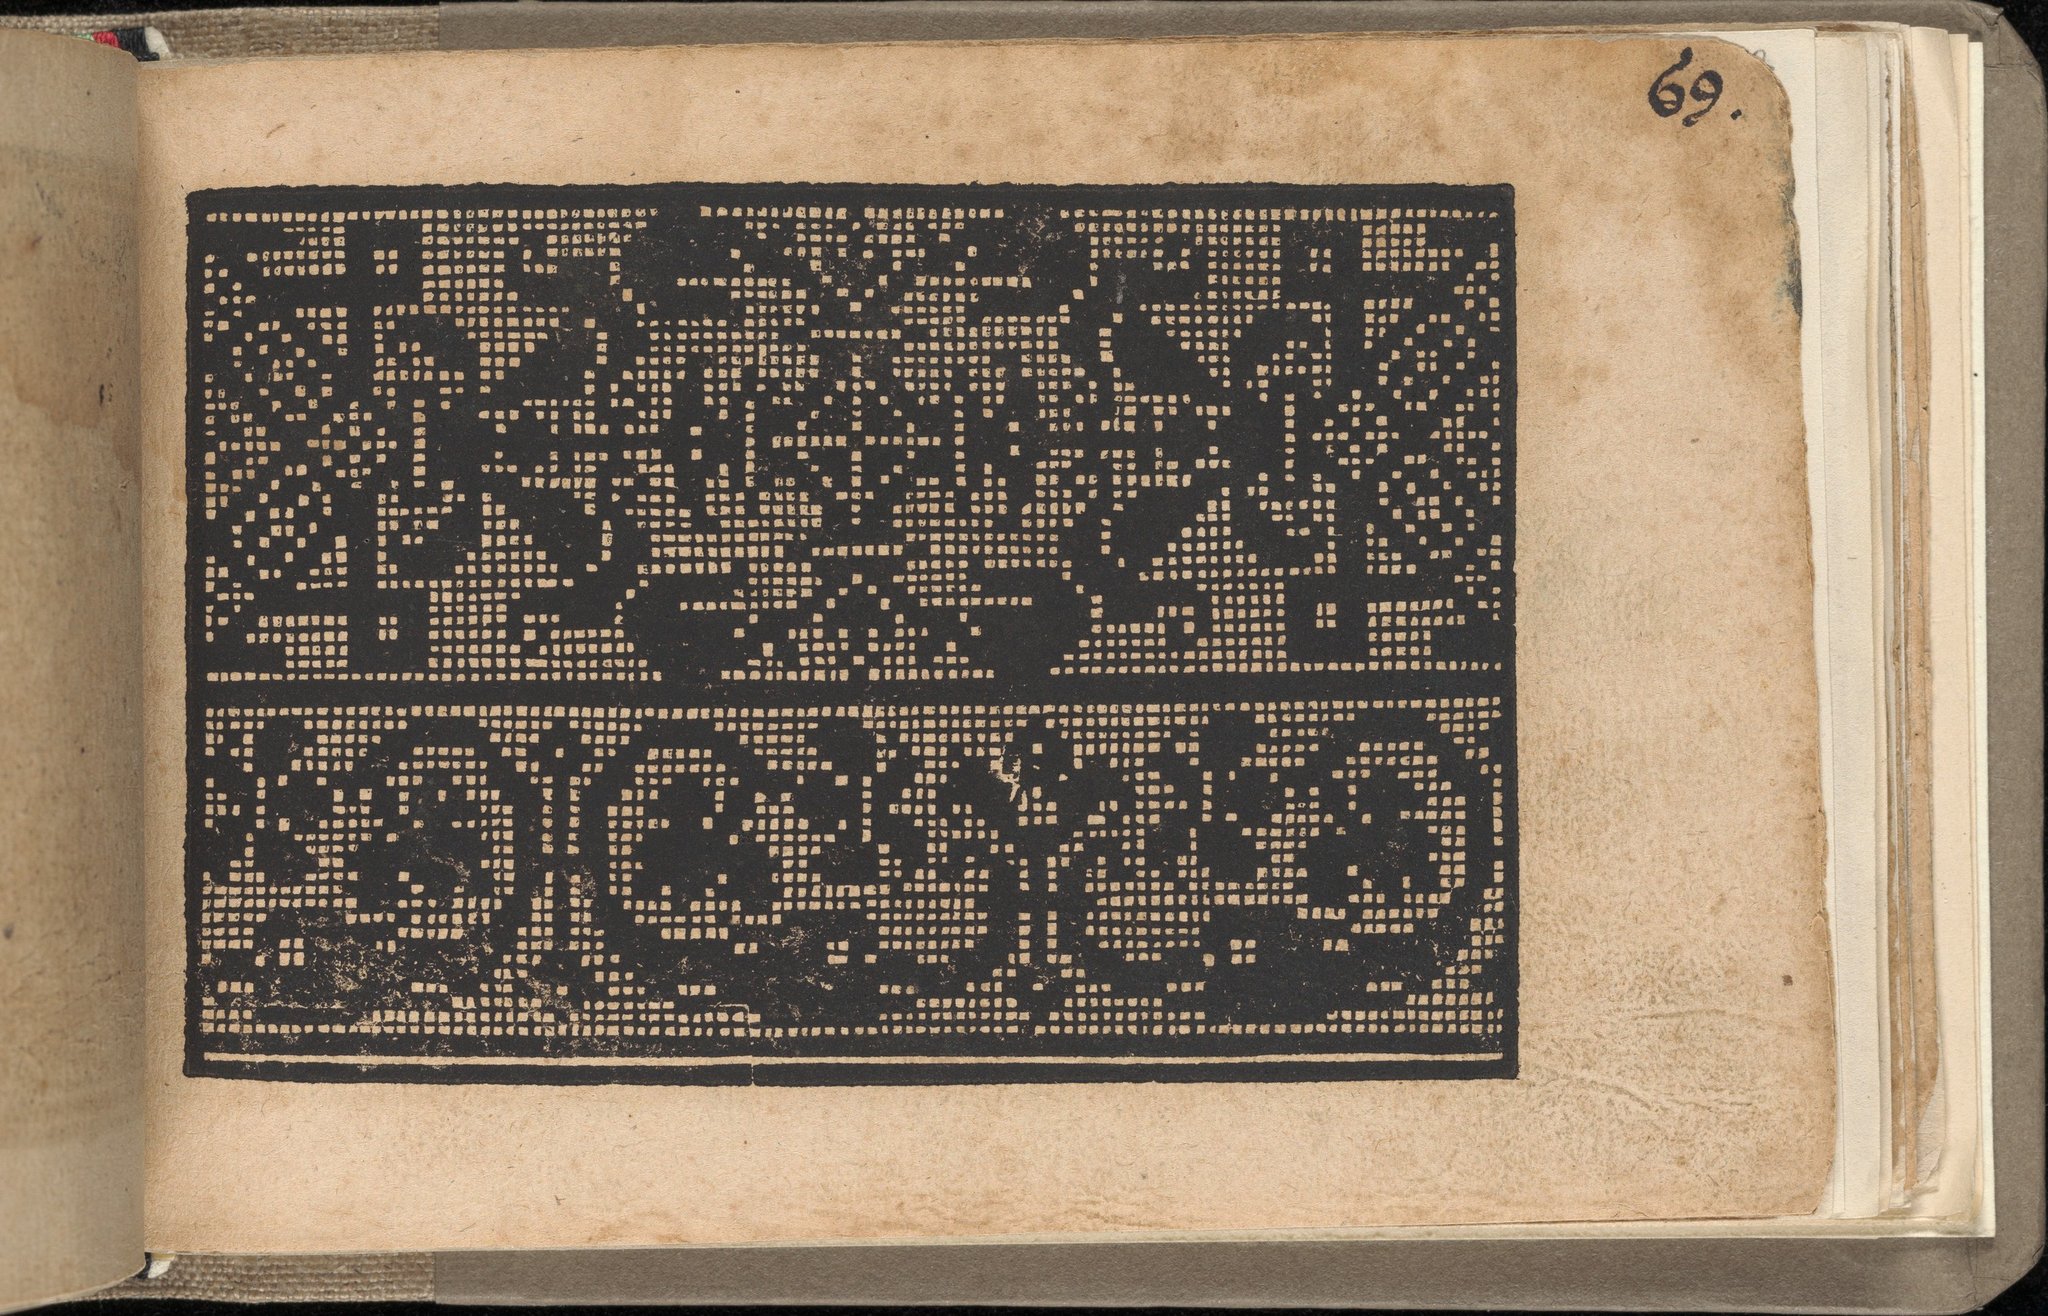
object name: book print ornament architecture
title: Schön newes Modelbuch (Page 69r)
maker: sigismundus latomus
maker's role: publisher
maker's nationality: german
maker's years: 1599-1632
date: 1608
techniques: woodcut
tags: ornament